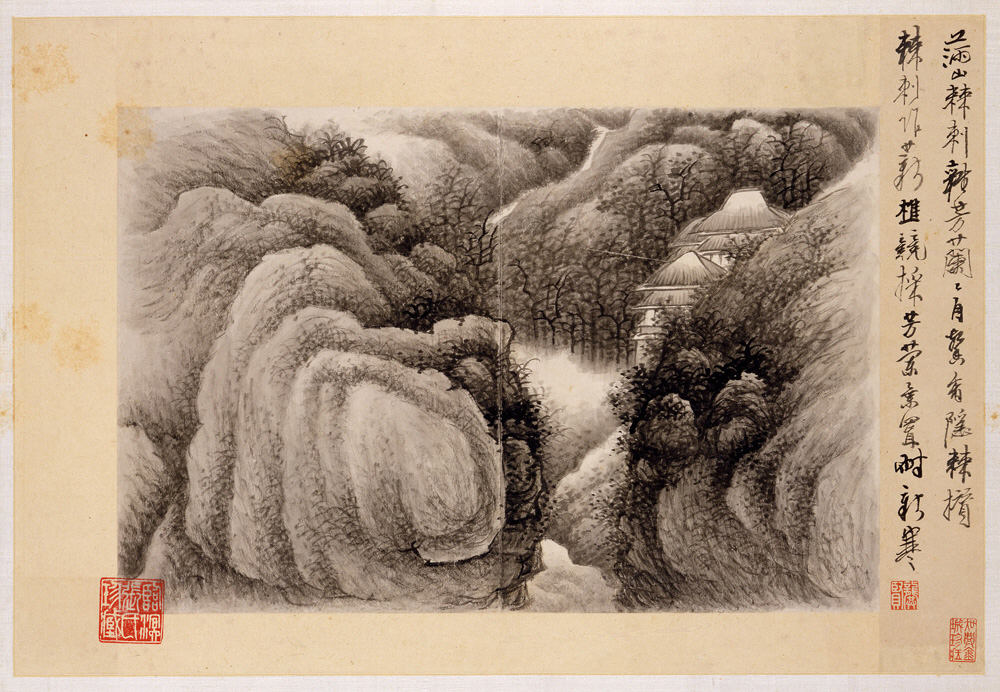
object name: album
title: Landscapes with poems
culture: chinese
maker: gong xian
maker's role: artist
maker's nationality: chinese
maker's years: 1619-1689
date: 1688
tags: poetry,landscapes